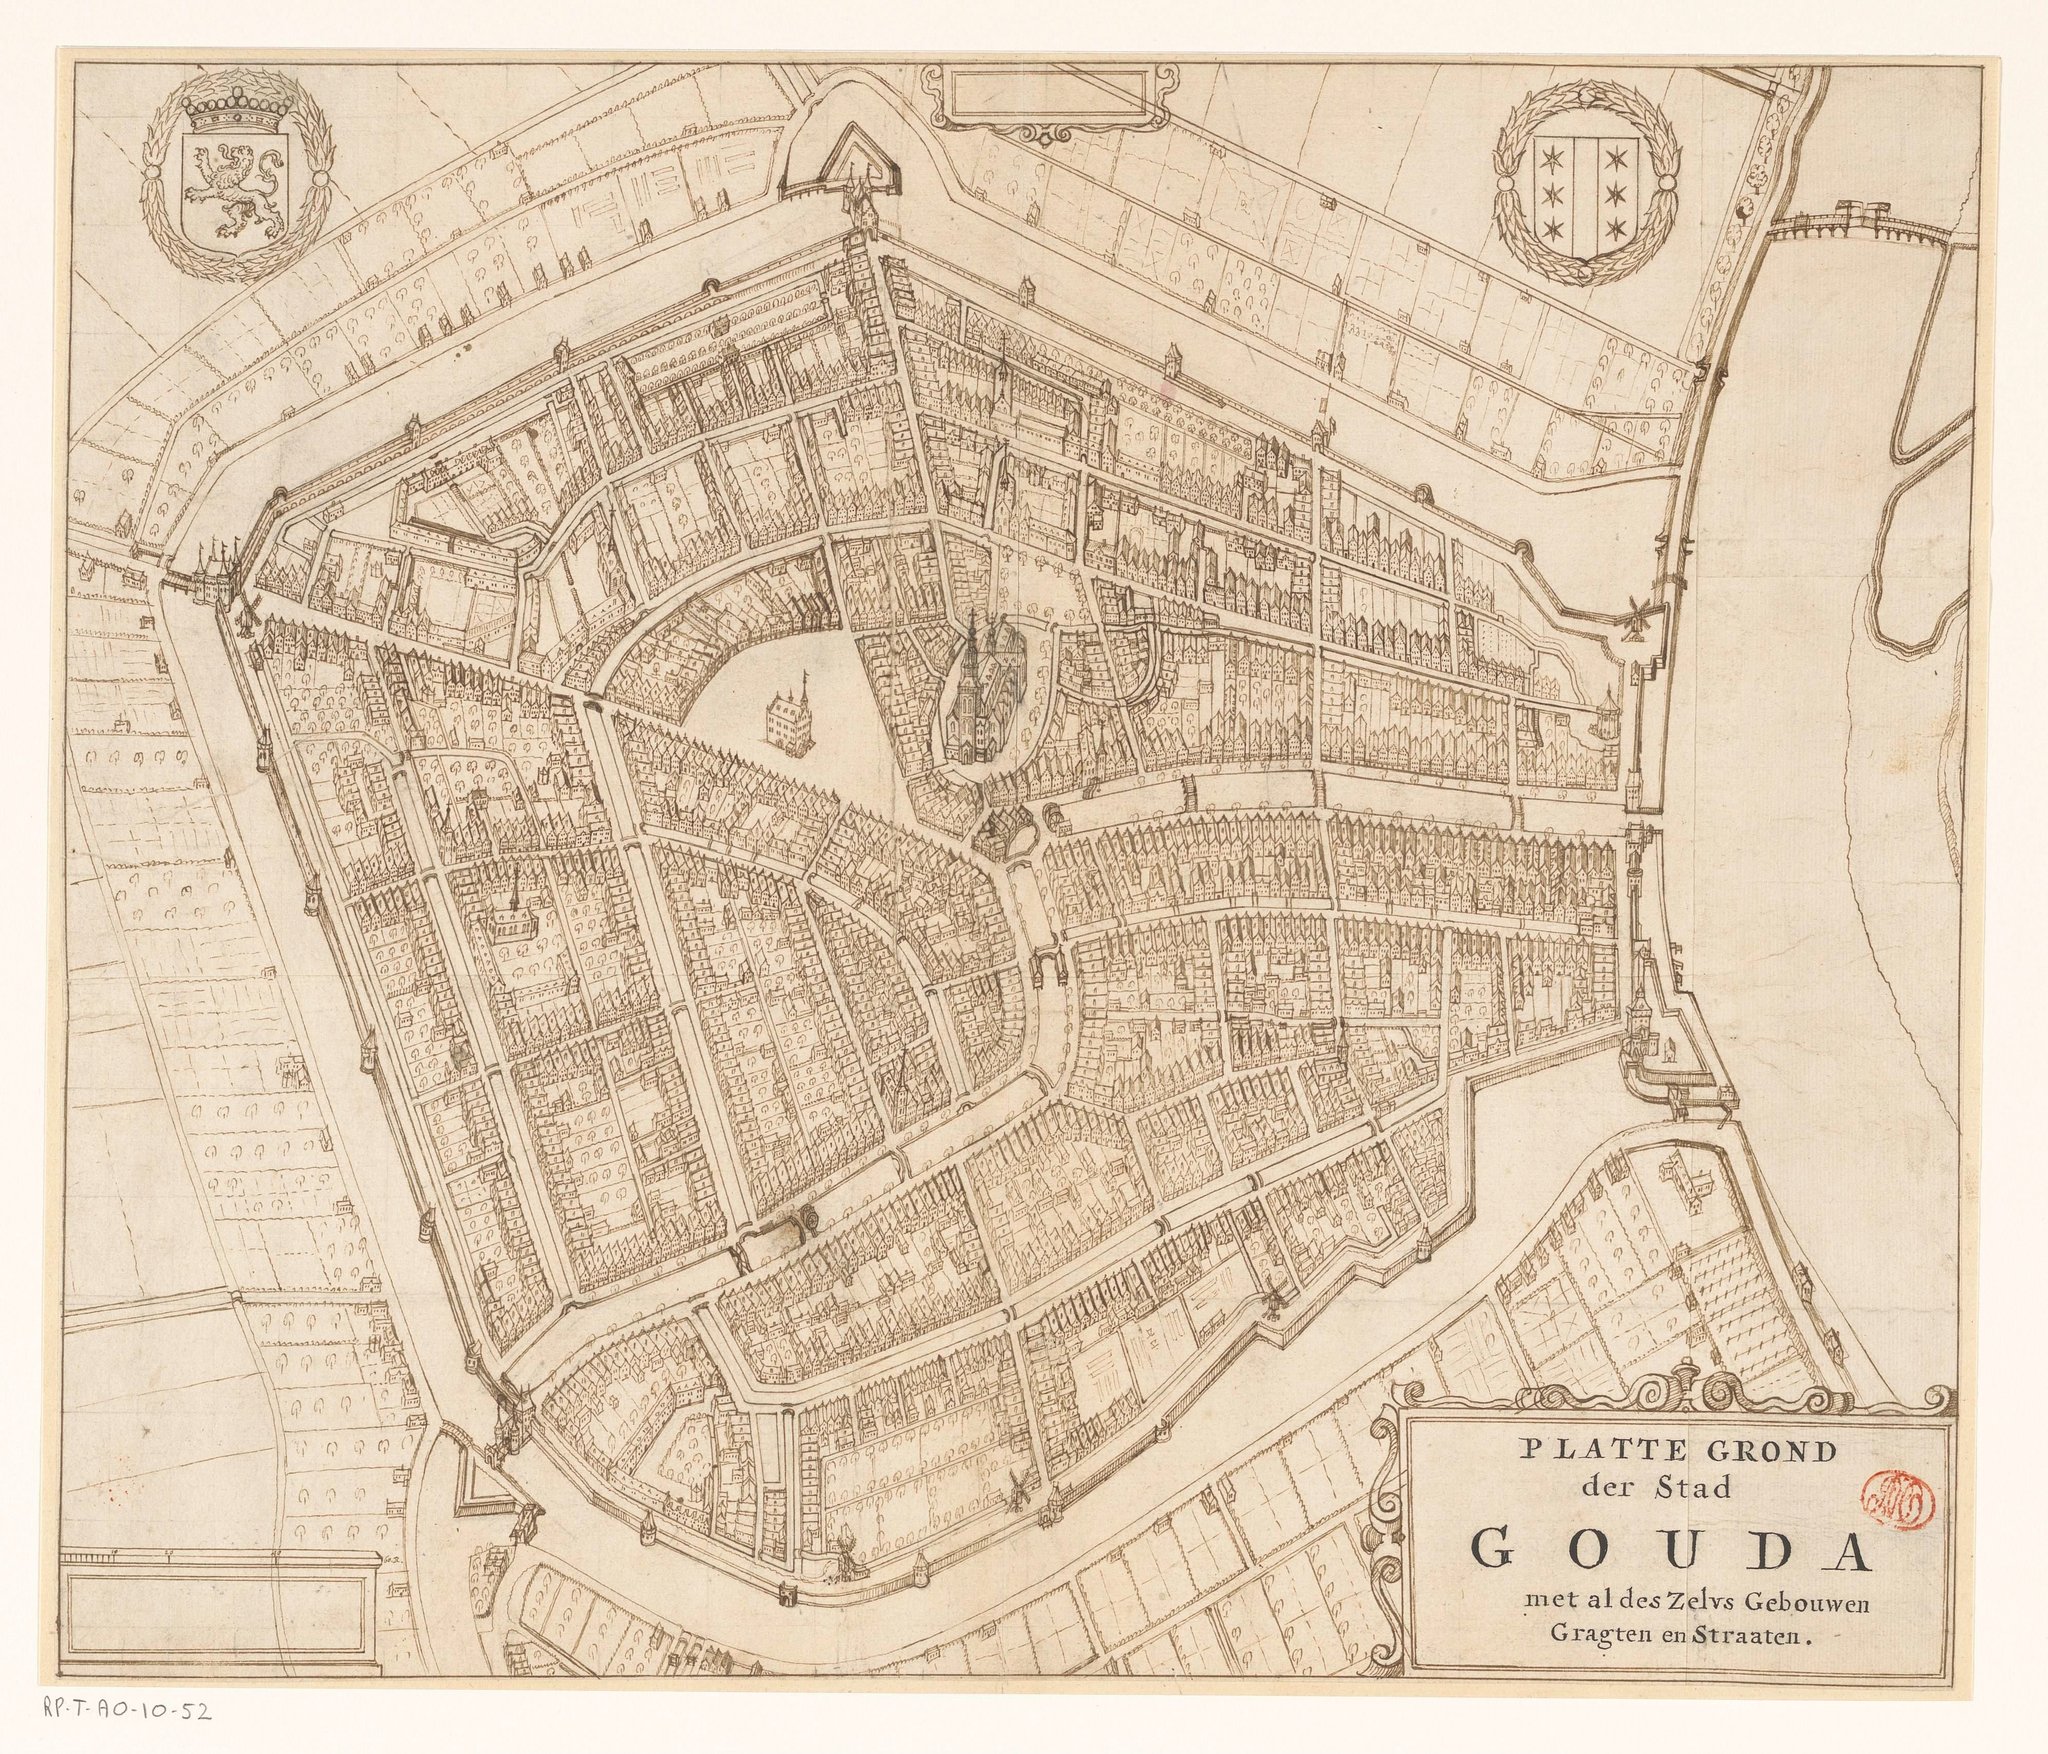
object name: area plan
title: Platte grond der stad Gouda met al des zelvs gebouwen gragten en straaten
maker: Anonymous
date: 1650-1749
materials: ink, paper, pencil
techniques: pen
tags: coat of arms (as symbol of the state, etc.) (+ city; municipal), maps of cities, coat of arms (as symbol of the state, etc.) (+ province; provincial), gouda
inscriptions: collector's mark: Lugt 2228, collector's mark: Lugt 195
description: Plattegrond in vogelvluchtperspectief. Linksboven het wapen van Holland. Boven in het midden een lege cartouche. Rechtsboven het wapen van Gouda. Linksonder een schaalstok van 60 roeden. Rechtsonder de titelcartouche.